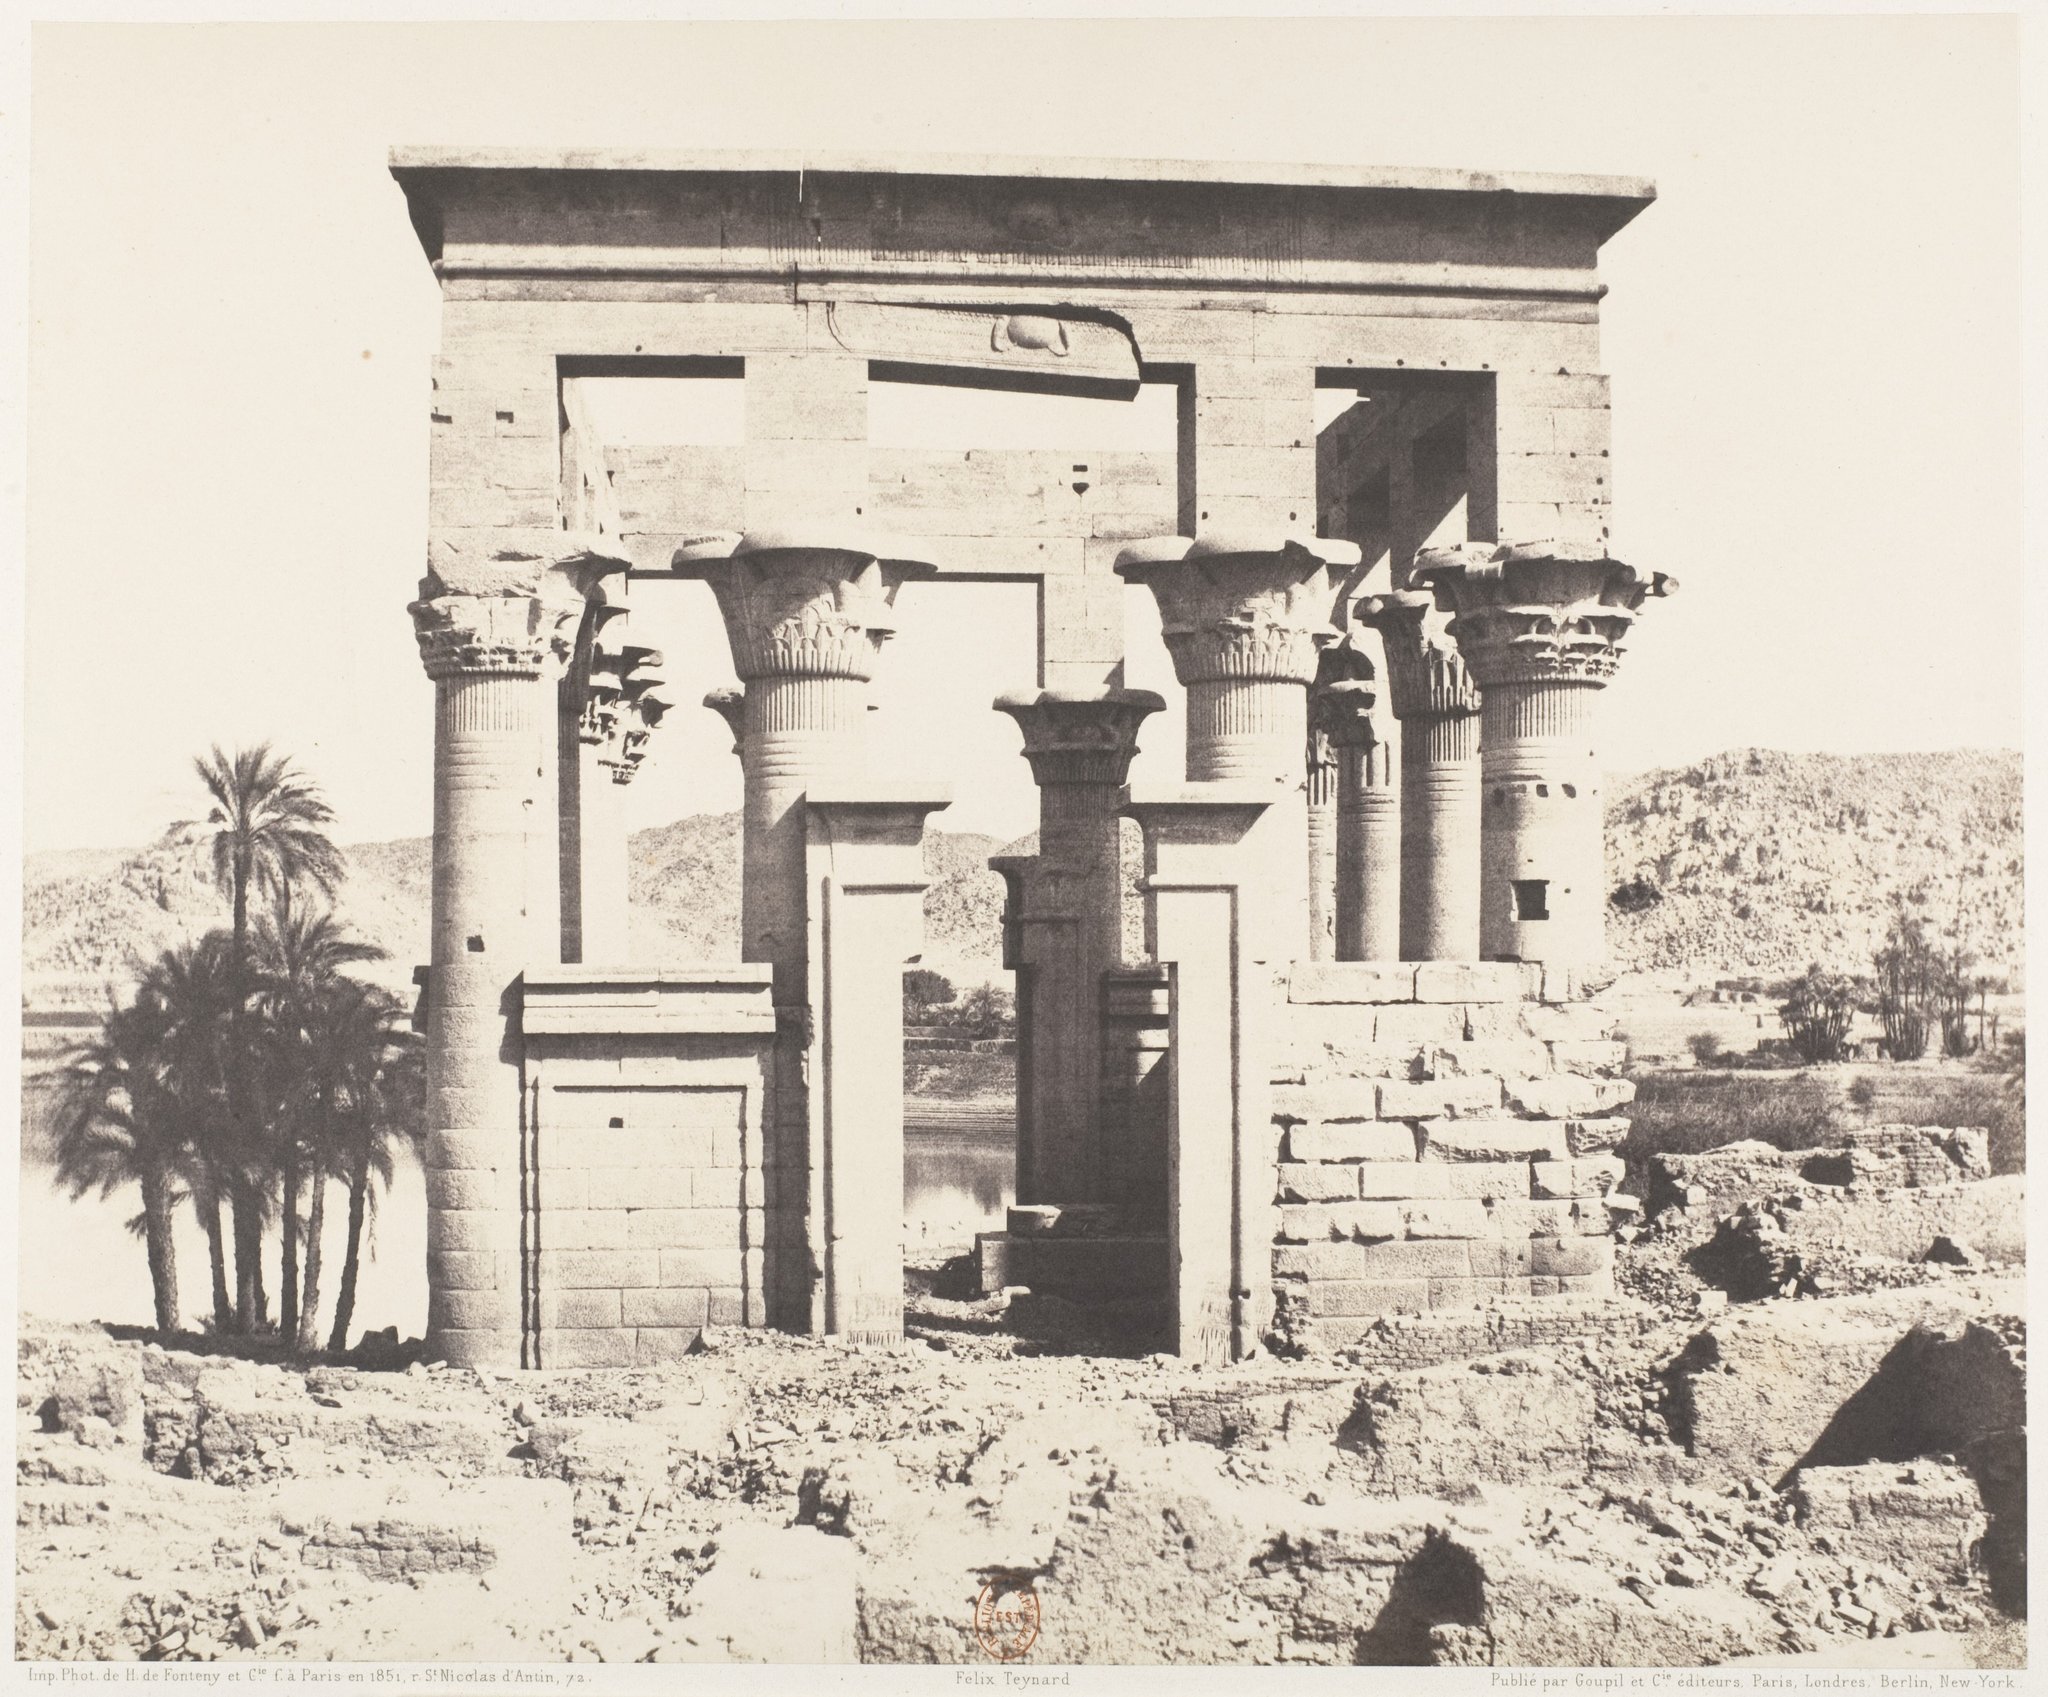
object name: photograph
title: Ile de Fîleh (Philæ), Édifice de l'Est - Façade Occidentale - Vue du Point E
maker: félix teynard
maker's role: artist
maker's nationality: french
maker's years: 1817-1892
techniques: paper negative, salted paper print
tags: architecture,ruins